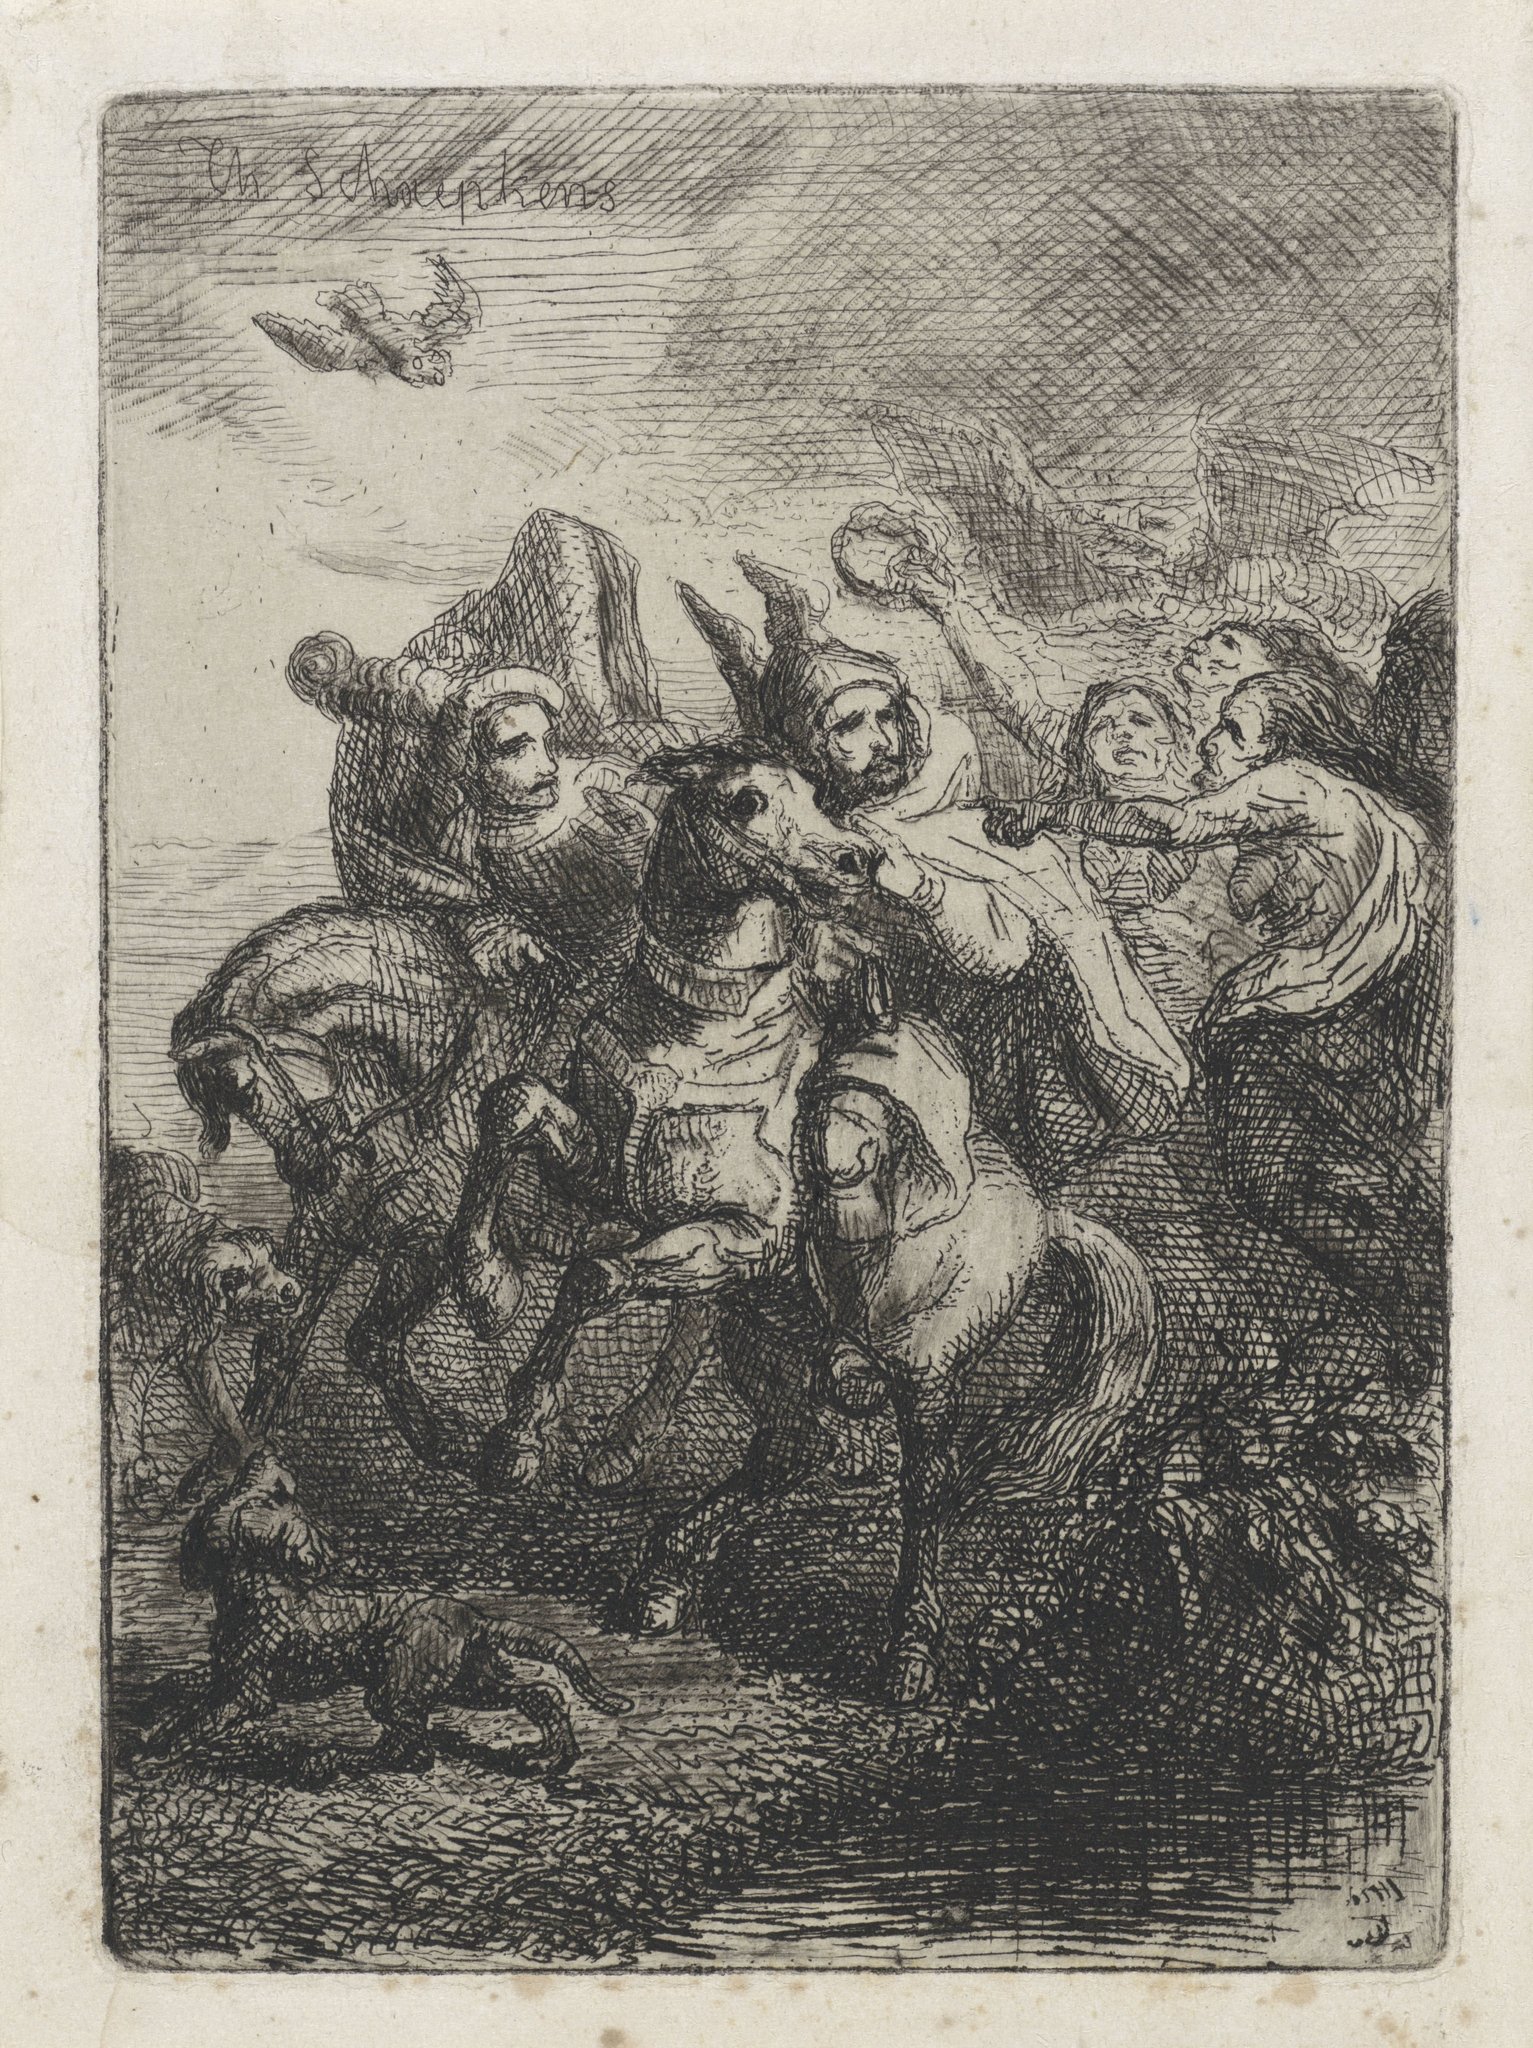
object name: print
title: Macbeth en Banquo ontmoeten de drie heksen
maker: theodoor schaepkens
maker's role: draughtsman, print maker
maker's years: 1810-1883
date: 1825-1883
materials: paper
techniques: drypoint, etching, roulette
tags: macbeth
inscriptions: collector's mark: Lugt 2228